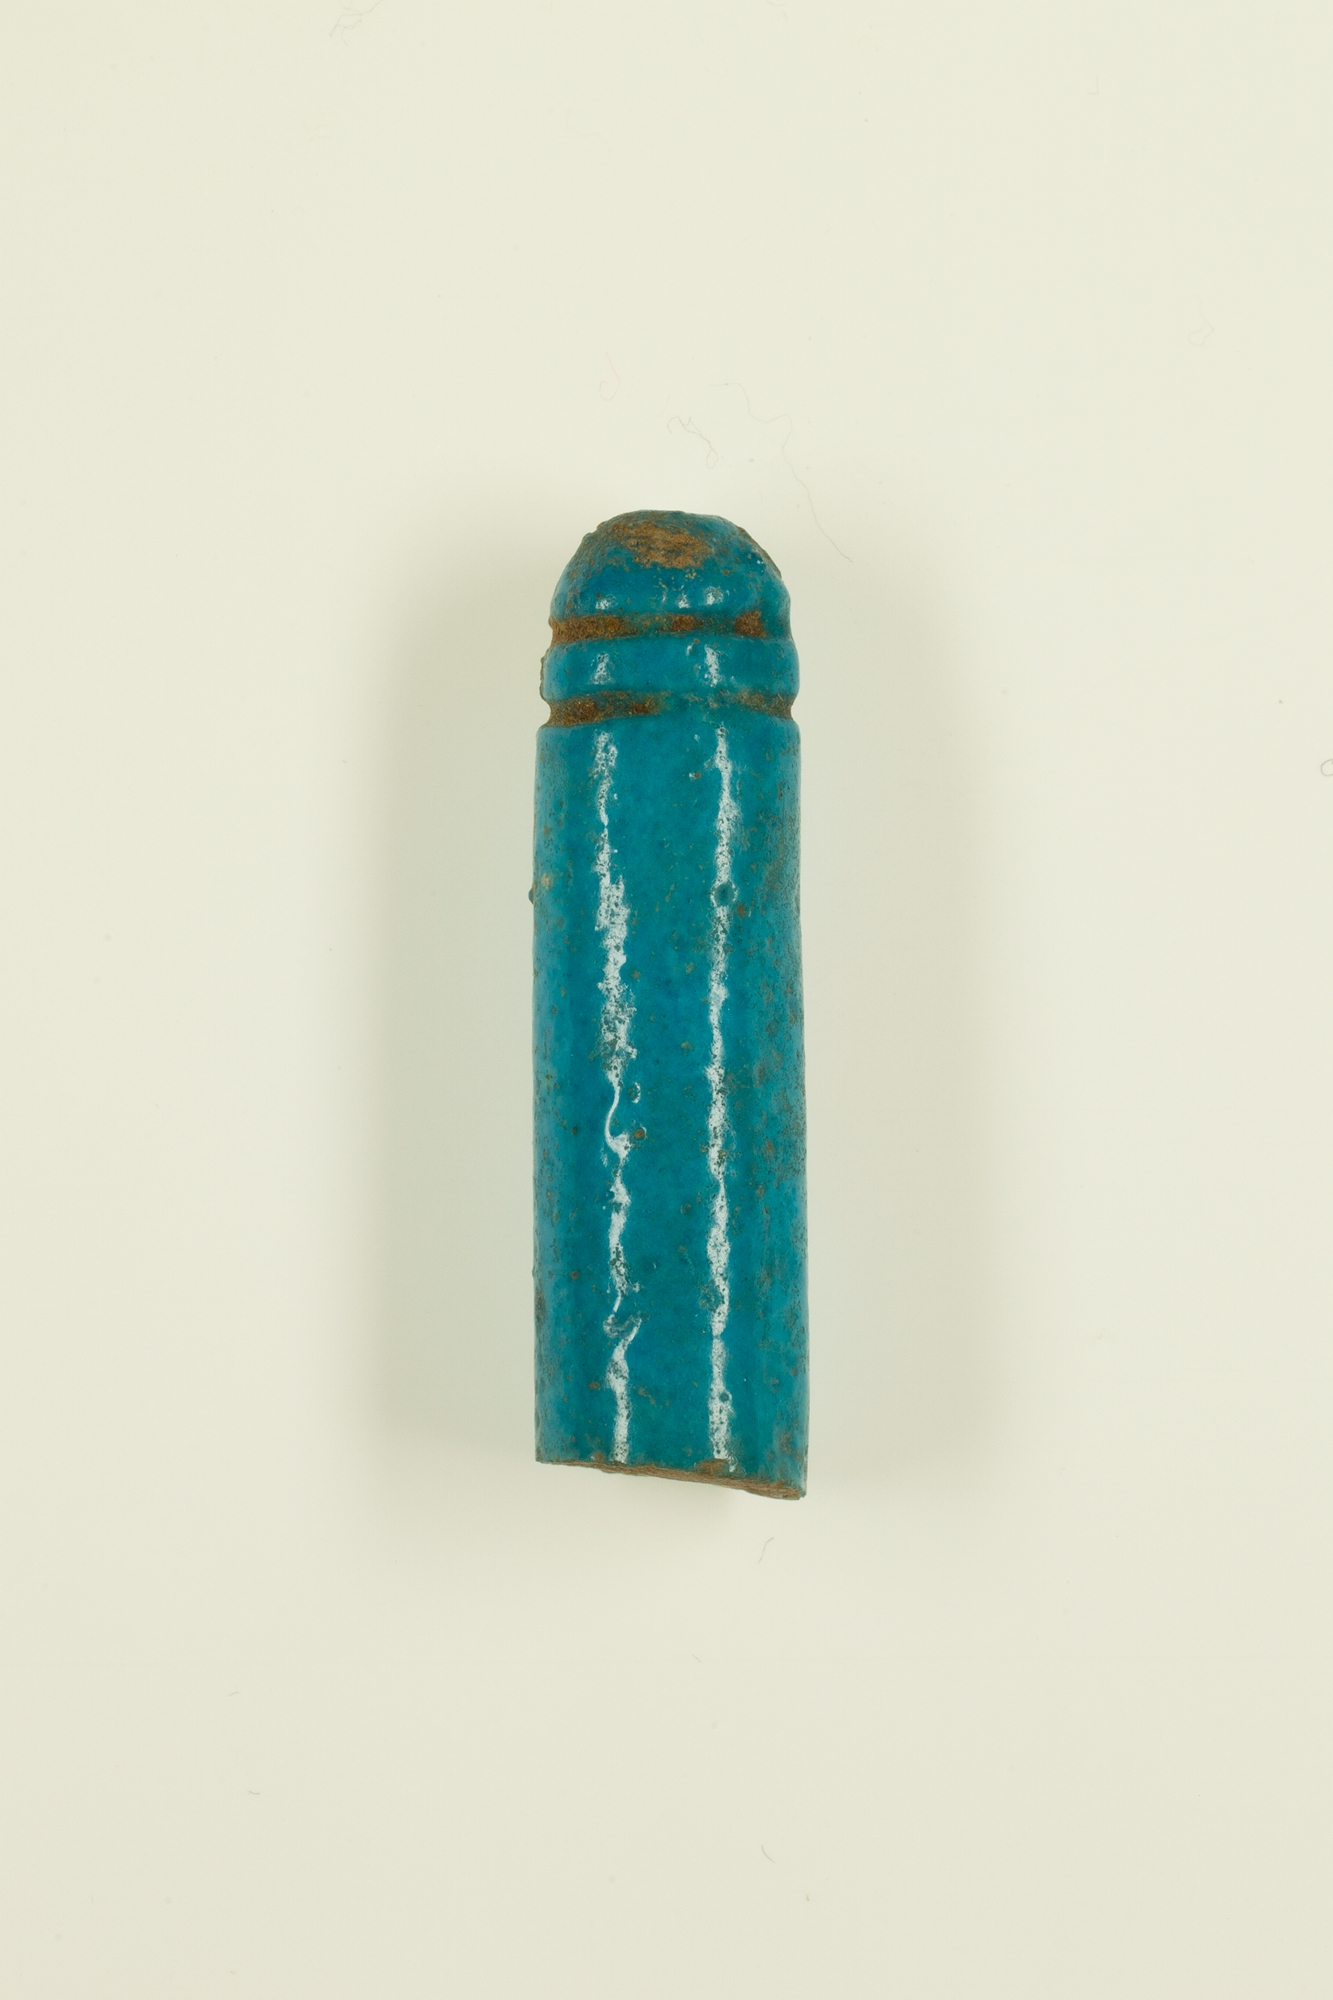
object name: bead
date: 1635-1458 BCE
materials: faience, paste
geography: egypt